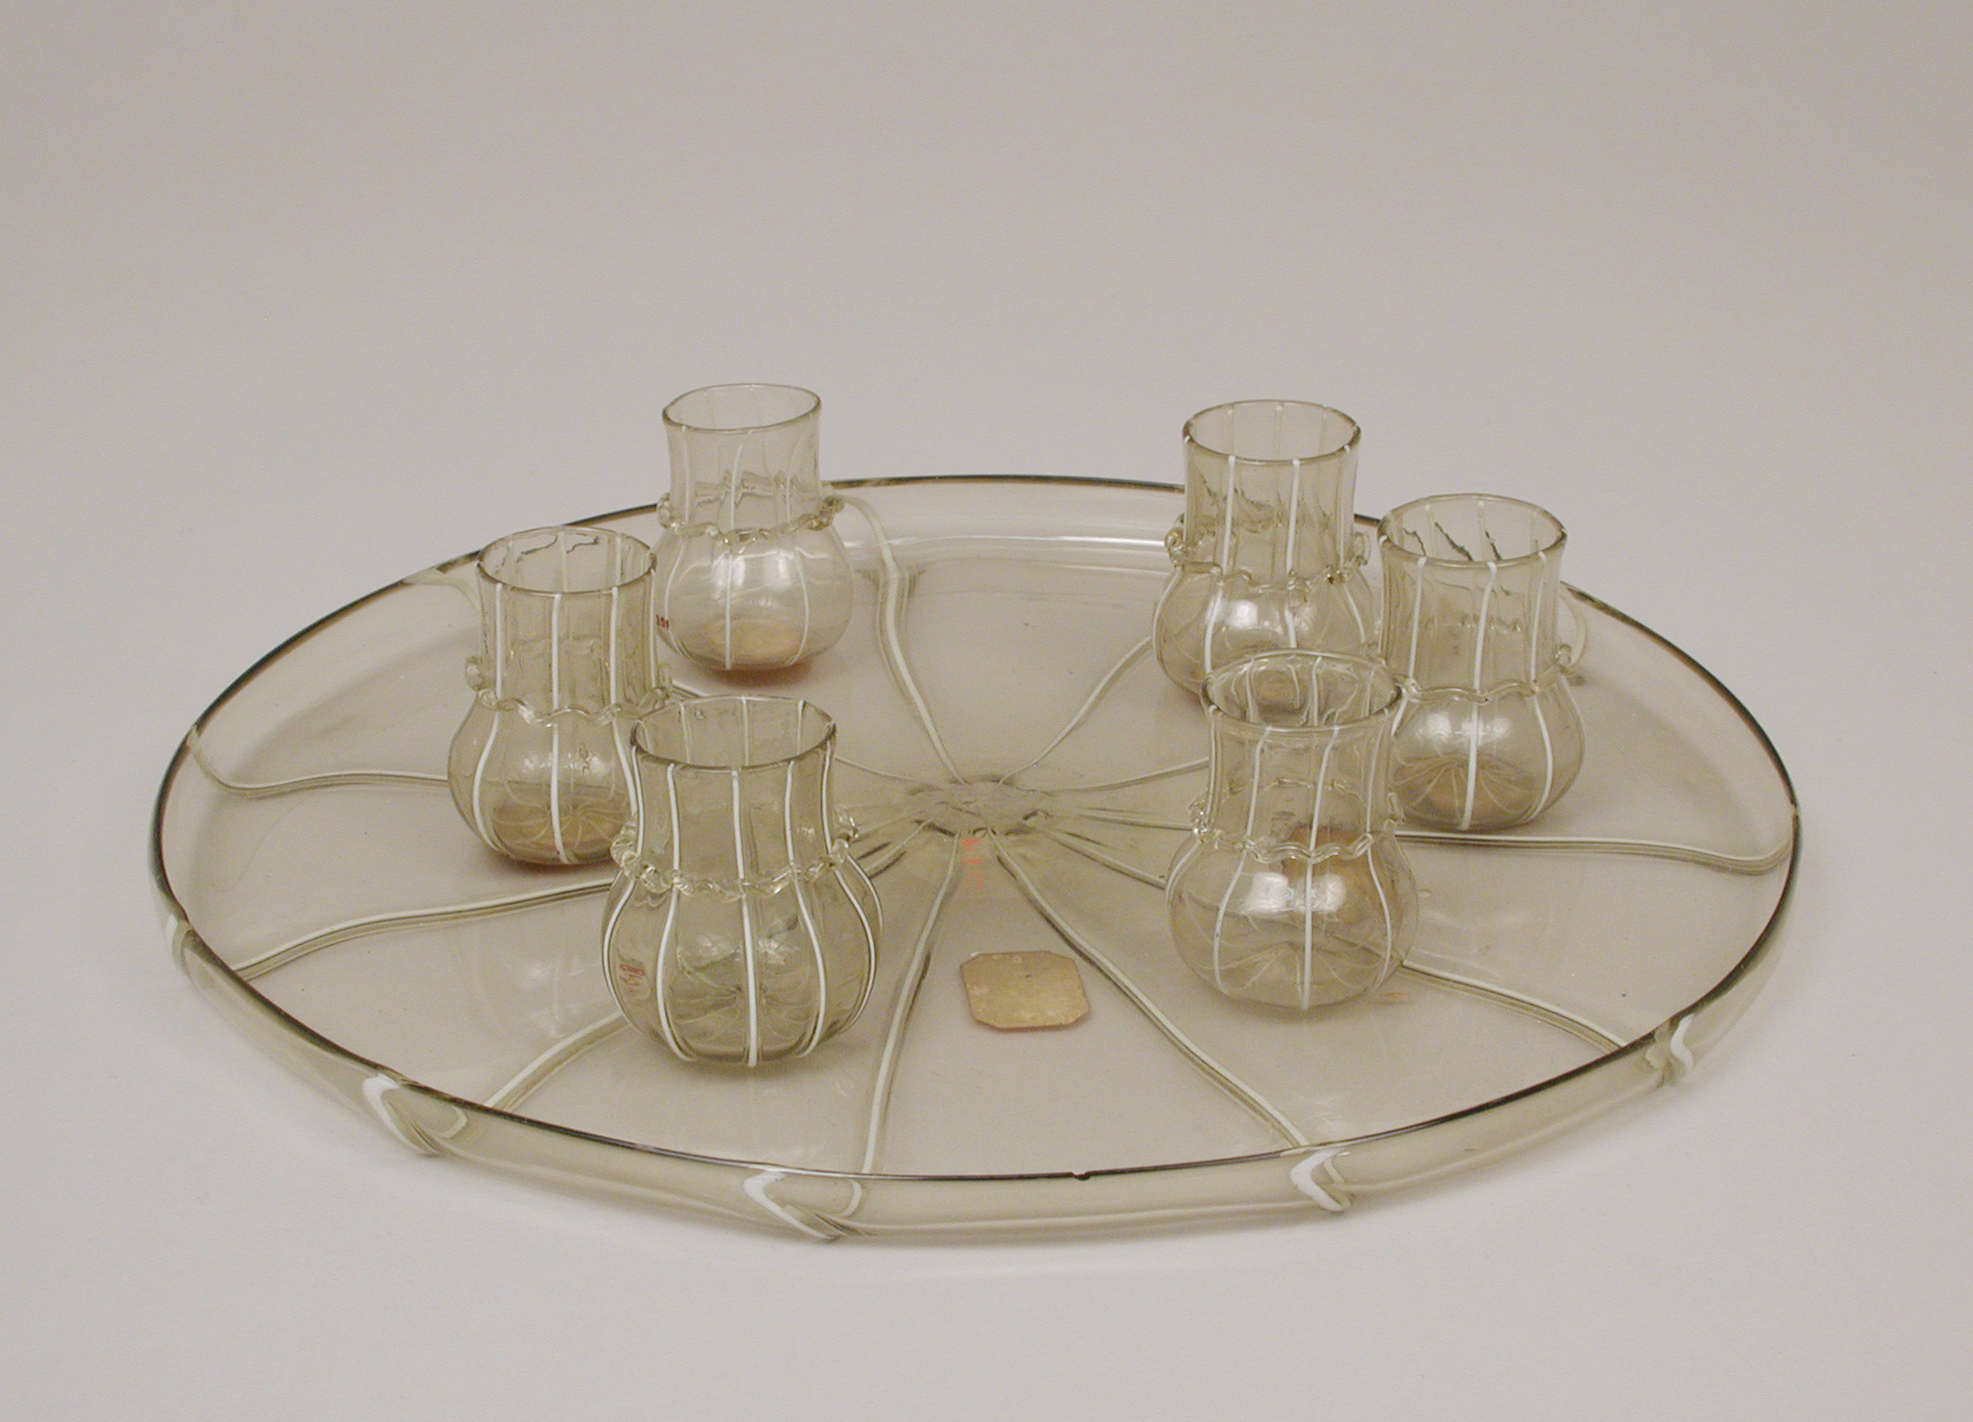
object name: schnapps glass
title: Schnapps glass (one of six)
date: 1801-1900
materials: glass